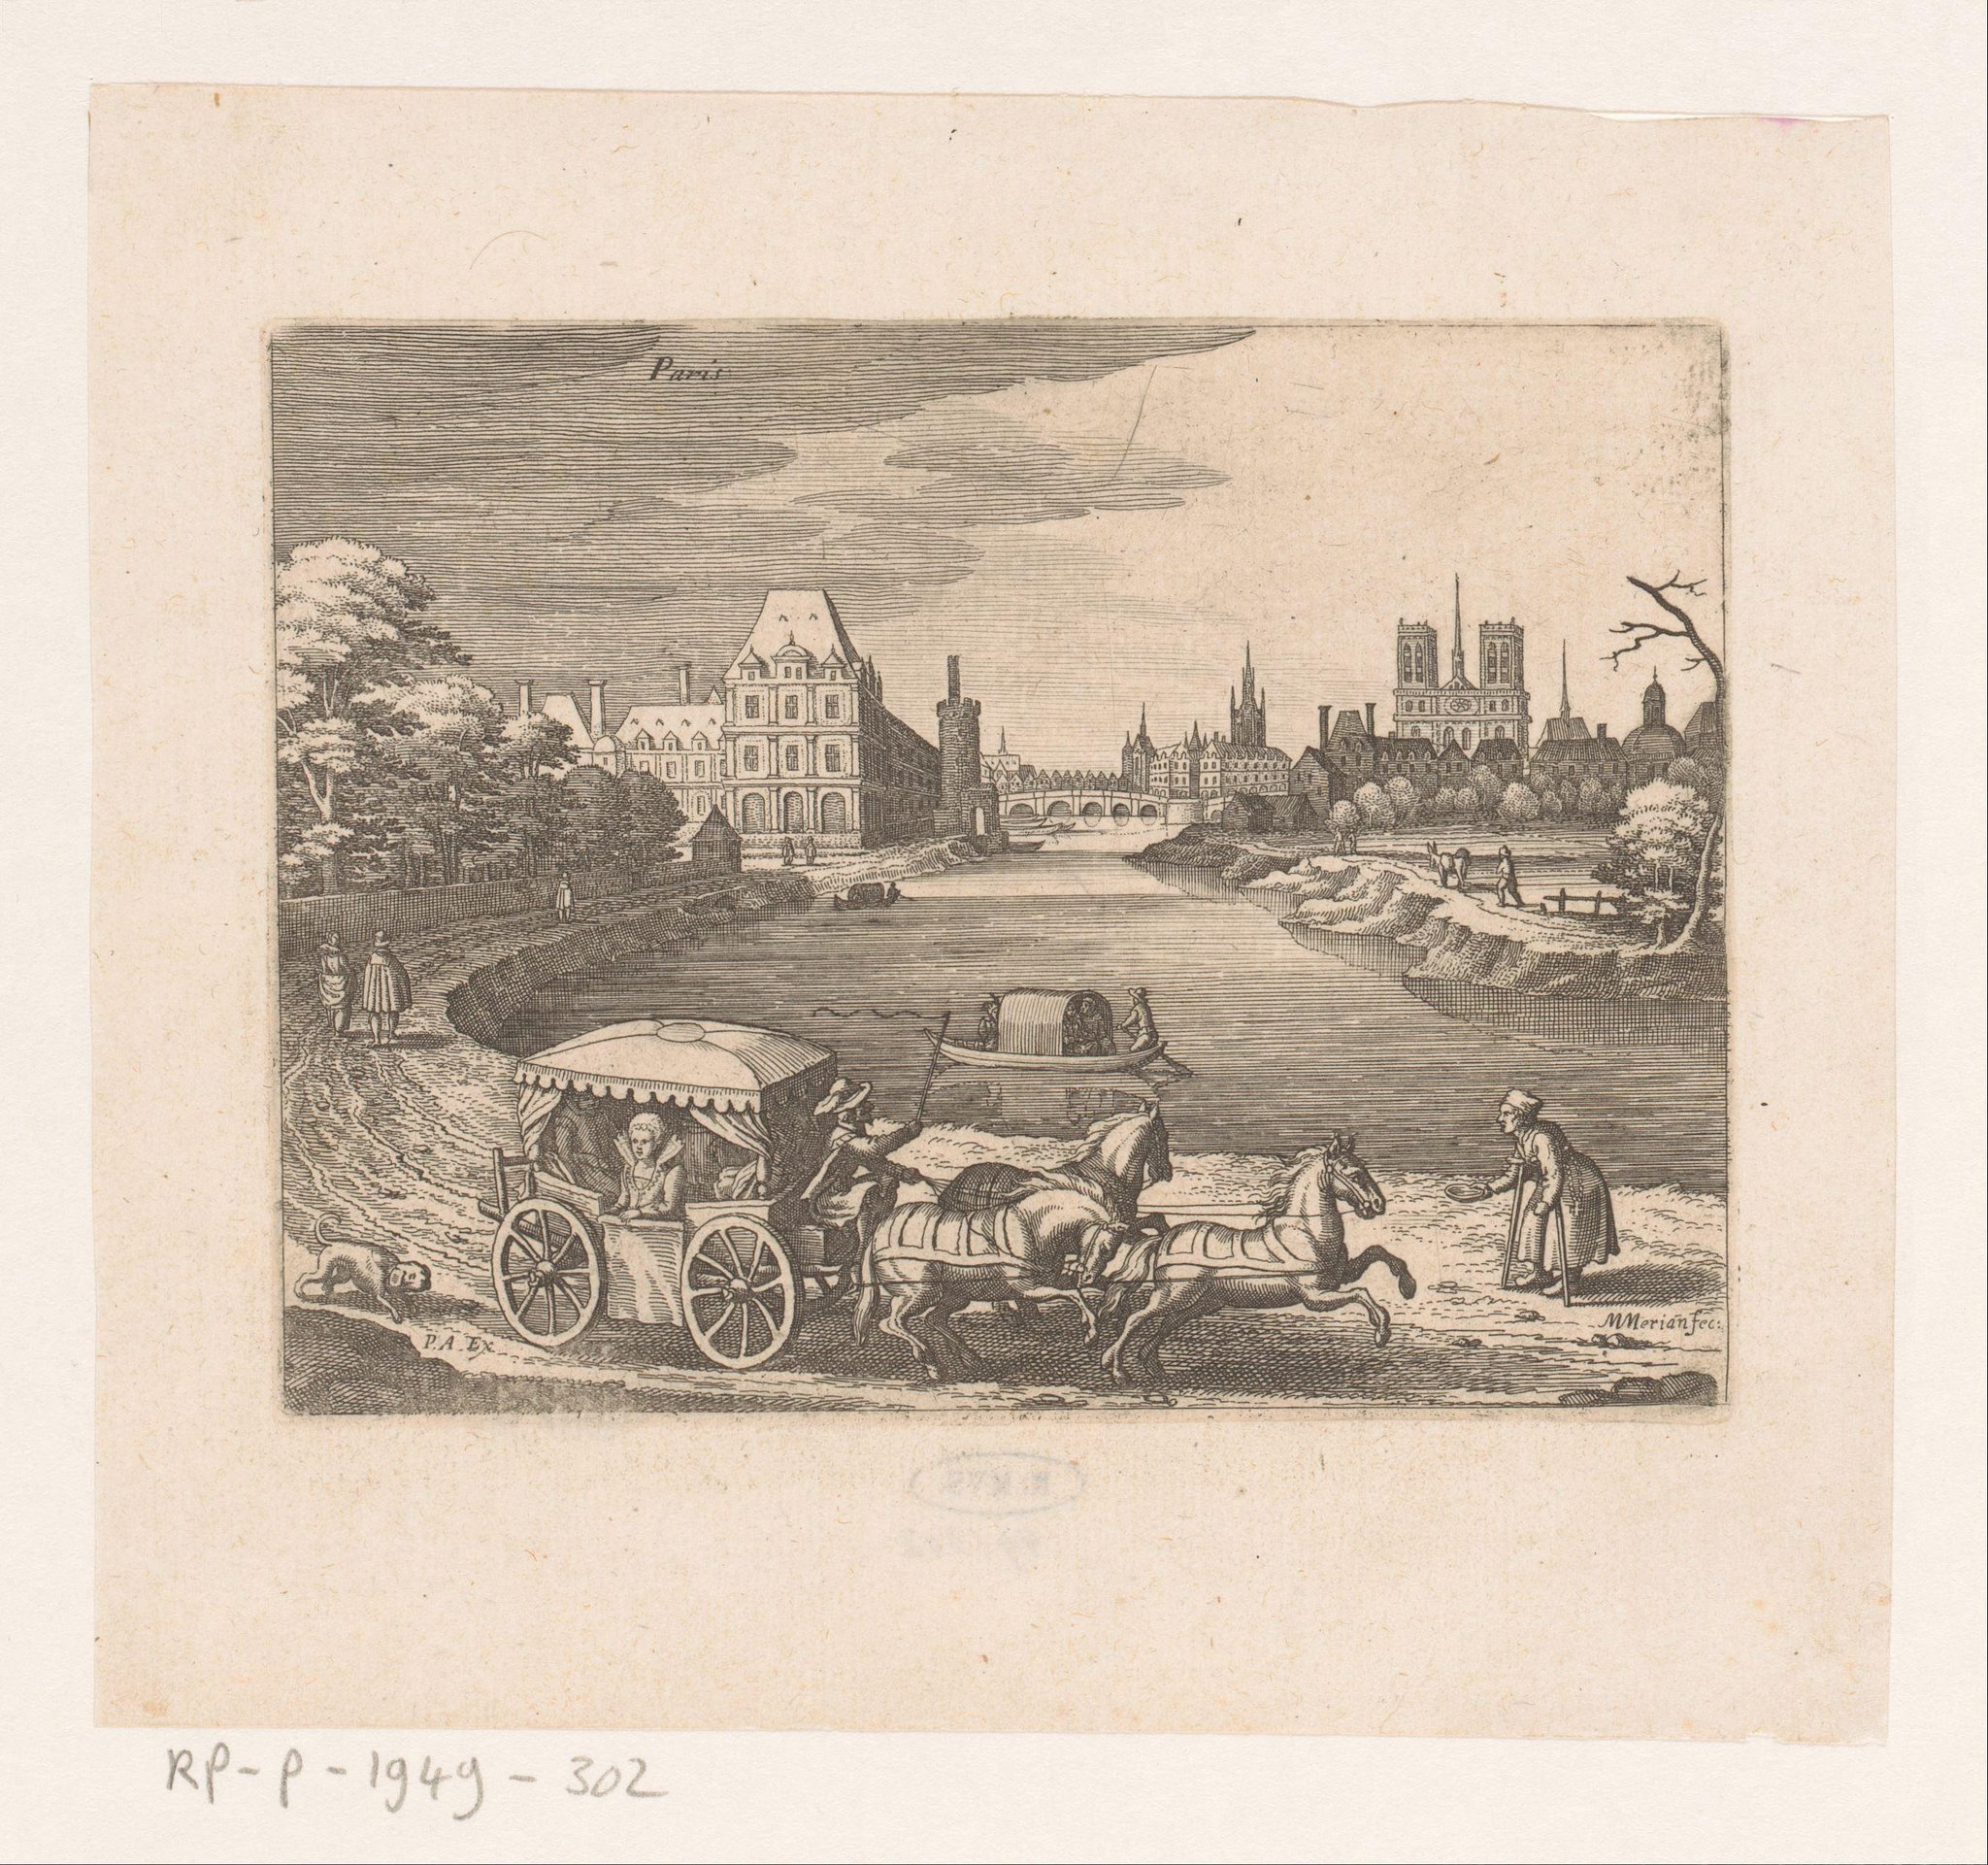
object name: print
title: Zeven Franse landschappen en stadsgezichten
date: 1603-1650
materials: paper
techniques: etching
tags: city-view in general; 'veduta', river (+ landscape with figures, staffage), beggar, passenger carriage, paris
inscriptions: collector's mark: Lugt 2228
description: Gezicht op de Seine met in de achtergrond de Notre Dame en het Louvre